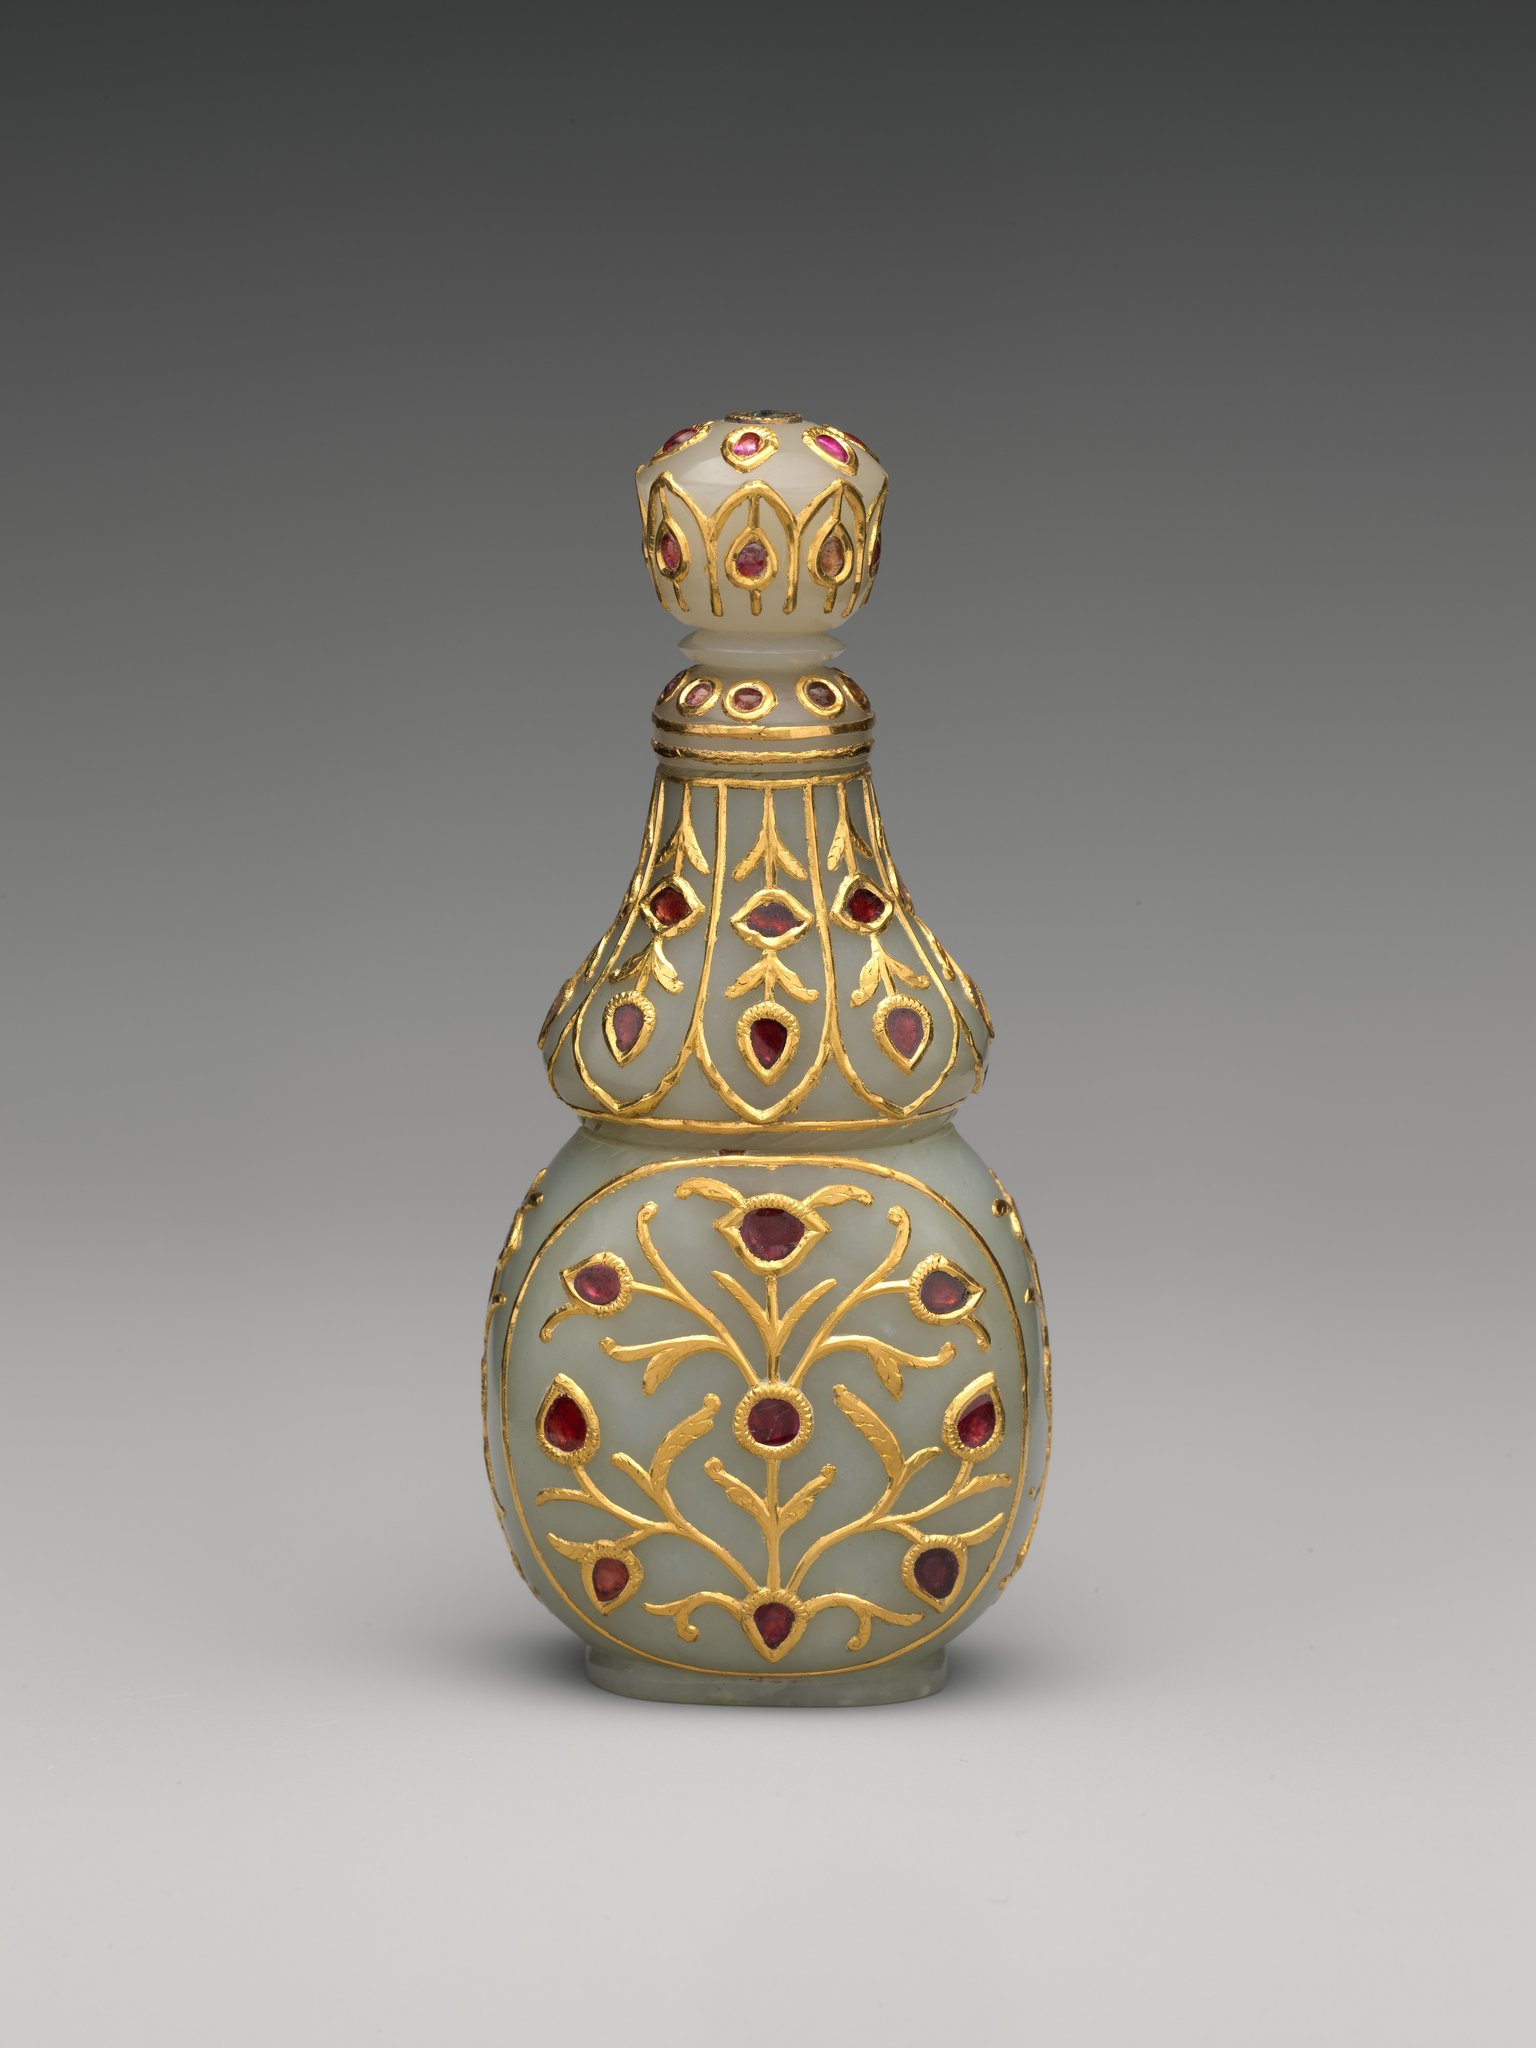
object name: vase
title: Vase with stopper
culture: indian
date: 1701-1900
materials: gold, jade, silver, stone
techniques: inlay